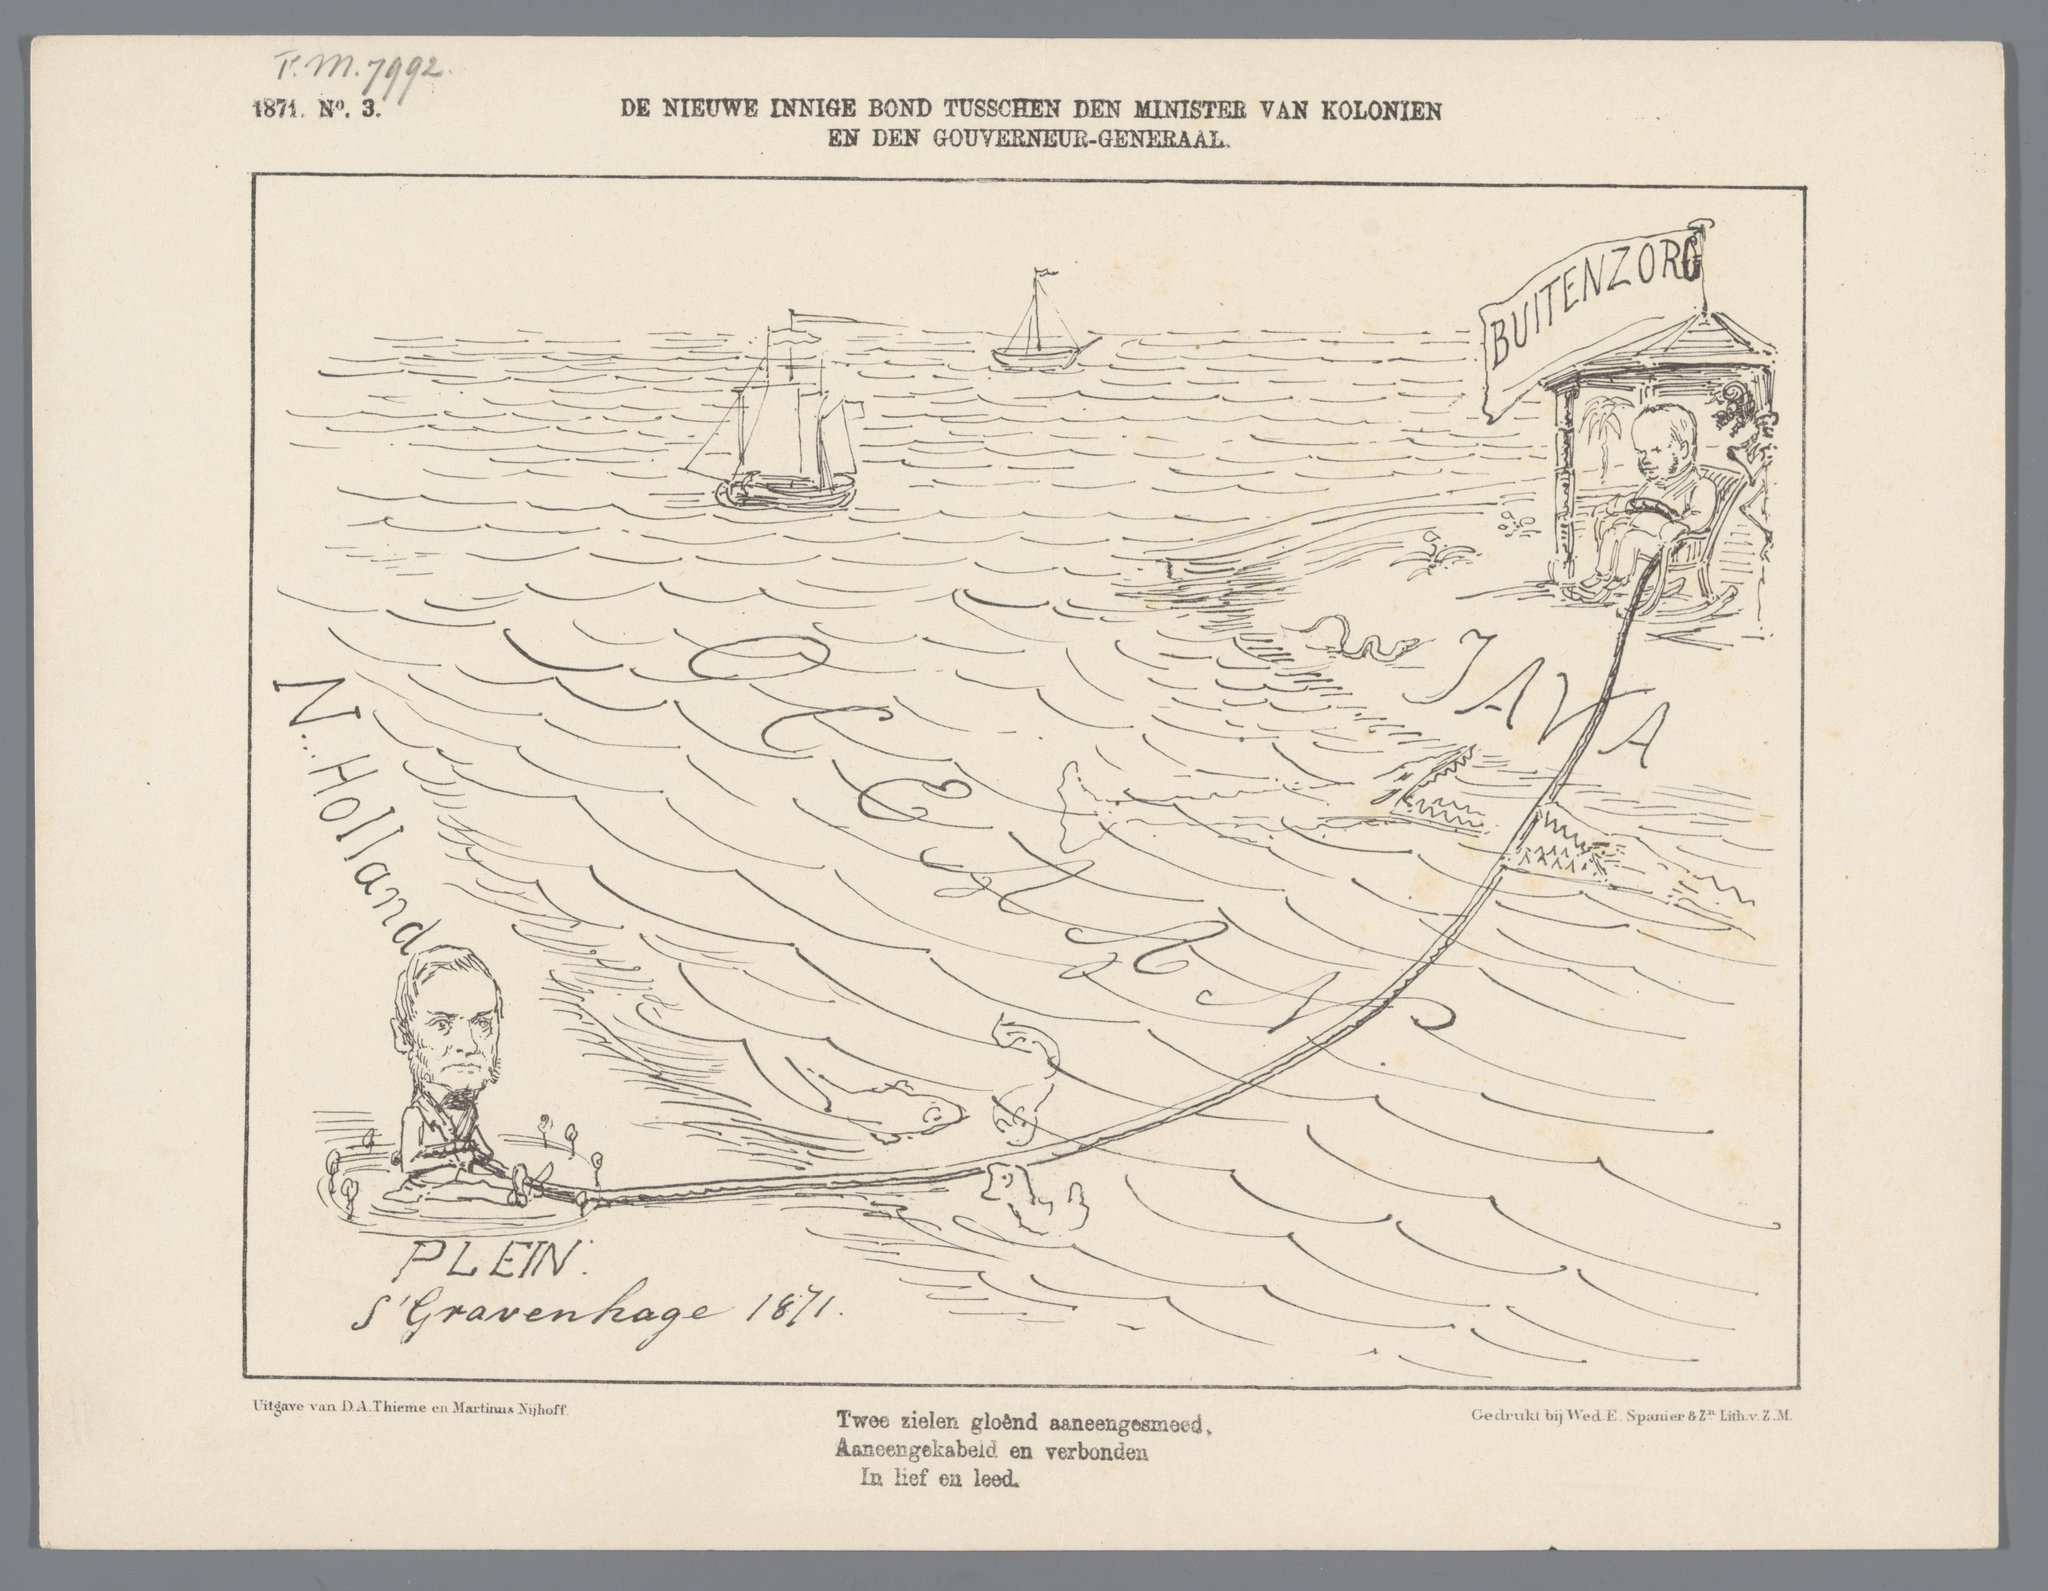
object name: cartoon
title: De nieuwe innige bond tusschen den minister van kolonien en den gouverneur-generaal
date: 1871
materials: paper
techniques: lithograph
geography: the hague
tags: amsterdam, politician, batavia, dutch east indies, the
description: Spotprent op Minister van Koloniën Van Bosse en gouverneur-generaal Mijer die met een overzeese kabel tussen Den Haag en Java aan elkaar verbonden zijn. Plaat verschenen bij het weekblad De Nederlandsche Spectator, nr. 3, 1871.